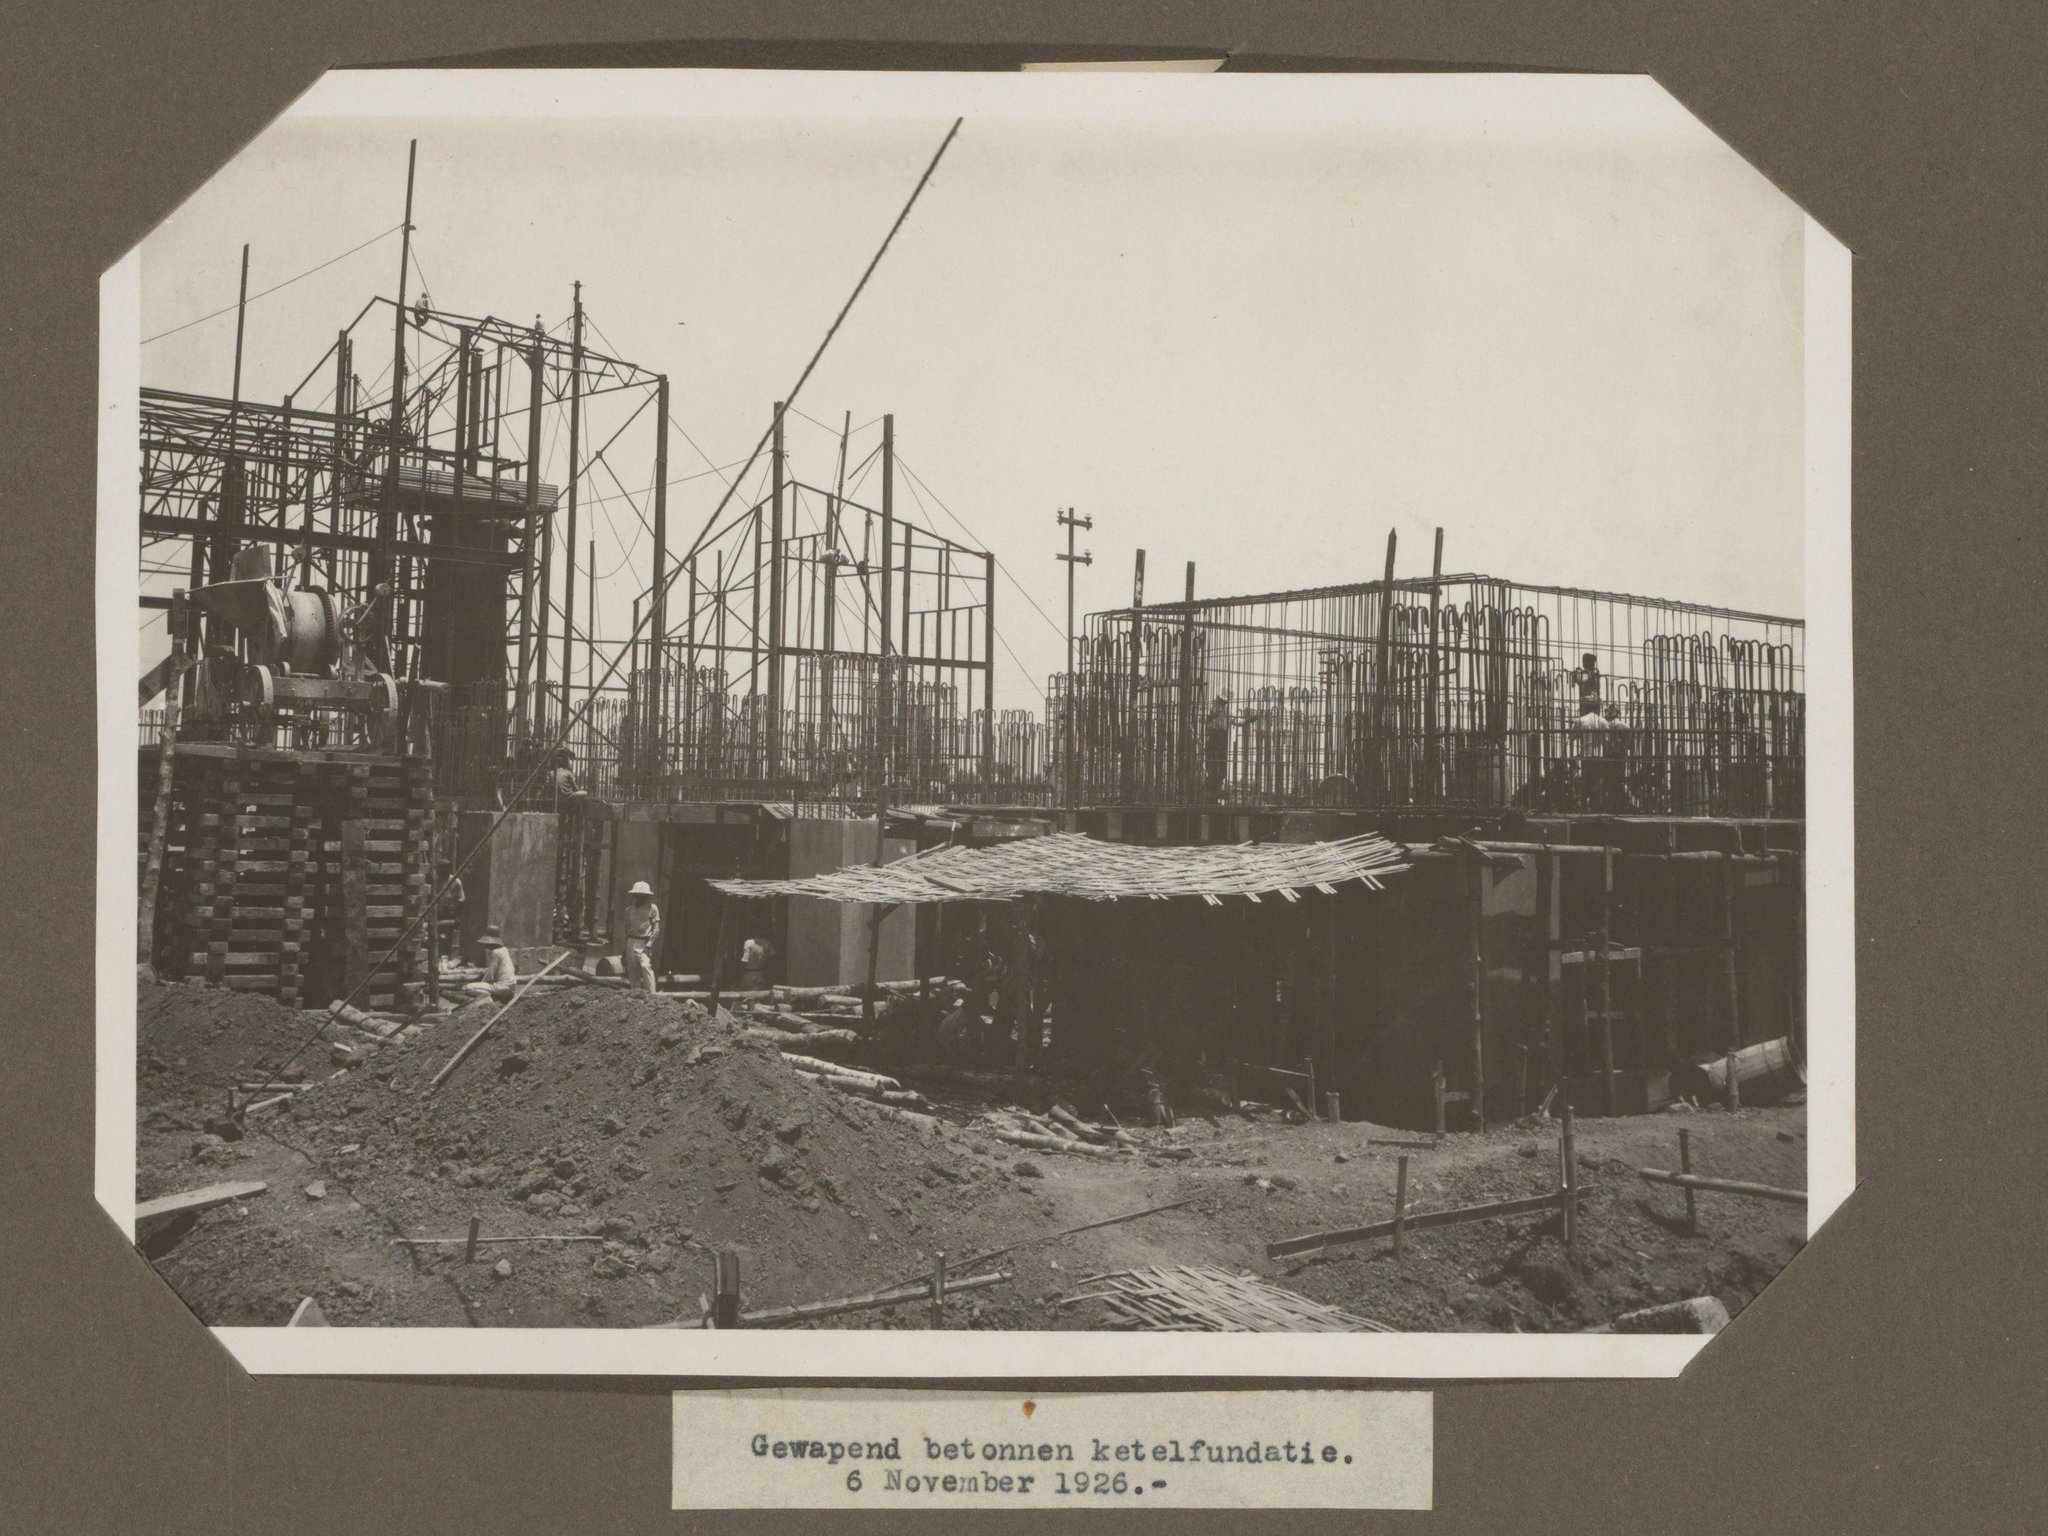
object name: photograph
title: Gewapend betonnen ketelfundatie. 6 November 1926.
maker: Anonymous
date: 1911-1926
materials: photographic support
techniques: gelatin silver print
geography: east java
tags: colonial system, trade-company, making the overground structures (~ building activities), industrial structures, (non-fruit) products of plants or trees: sugarcane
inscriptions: inscription: ‘Gewapend betonnen ketelfundatie. 6 November 1926.’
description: Bouw van de muren van het ketelgebouw van gewapend beton, 6 november 1926. Onderdeel van het fotoalbum met foto's van de opbouw van de suikerfabriek te Goenoengsari op Oost-Java door de Handels Vereniging Amsterdam 1926-1927.